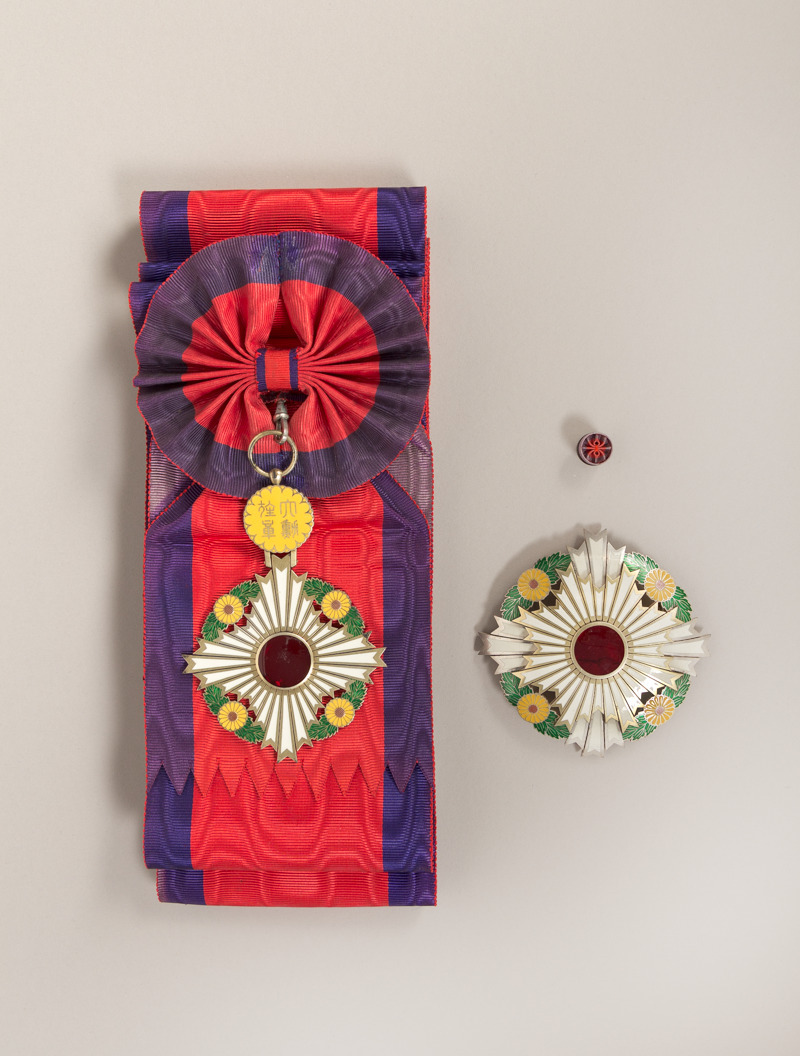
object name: insignia, medal and button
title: Insignia of the Supreme Order of the Chrysanthemum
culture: japanese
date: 1867-1900